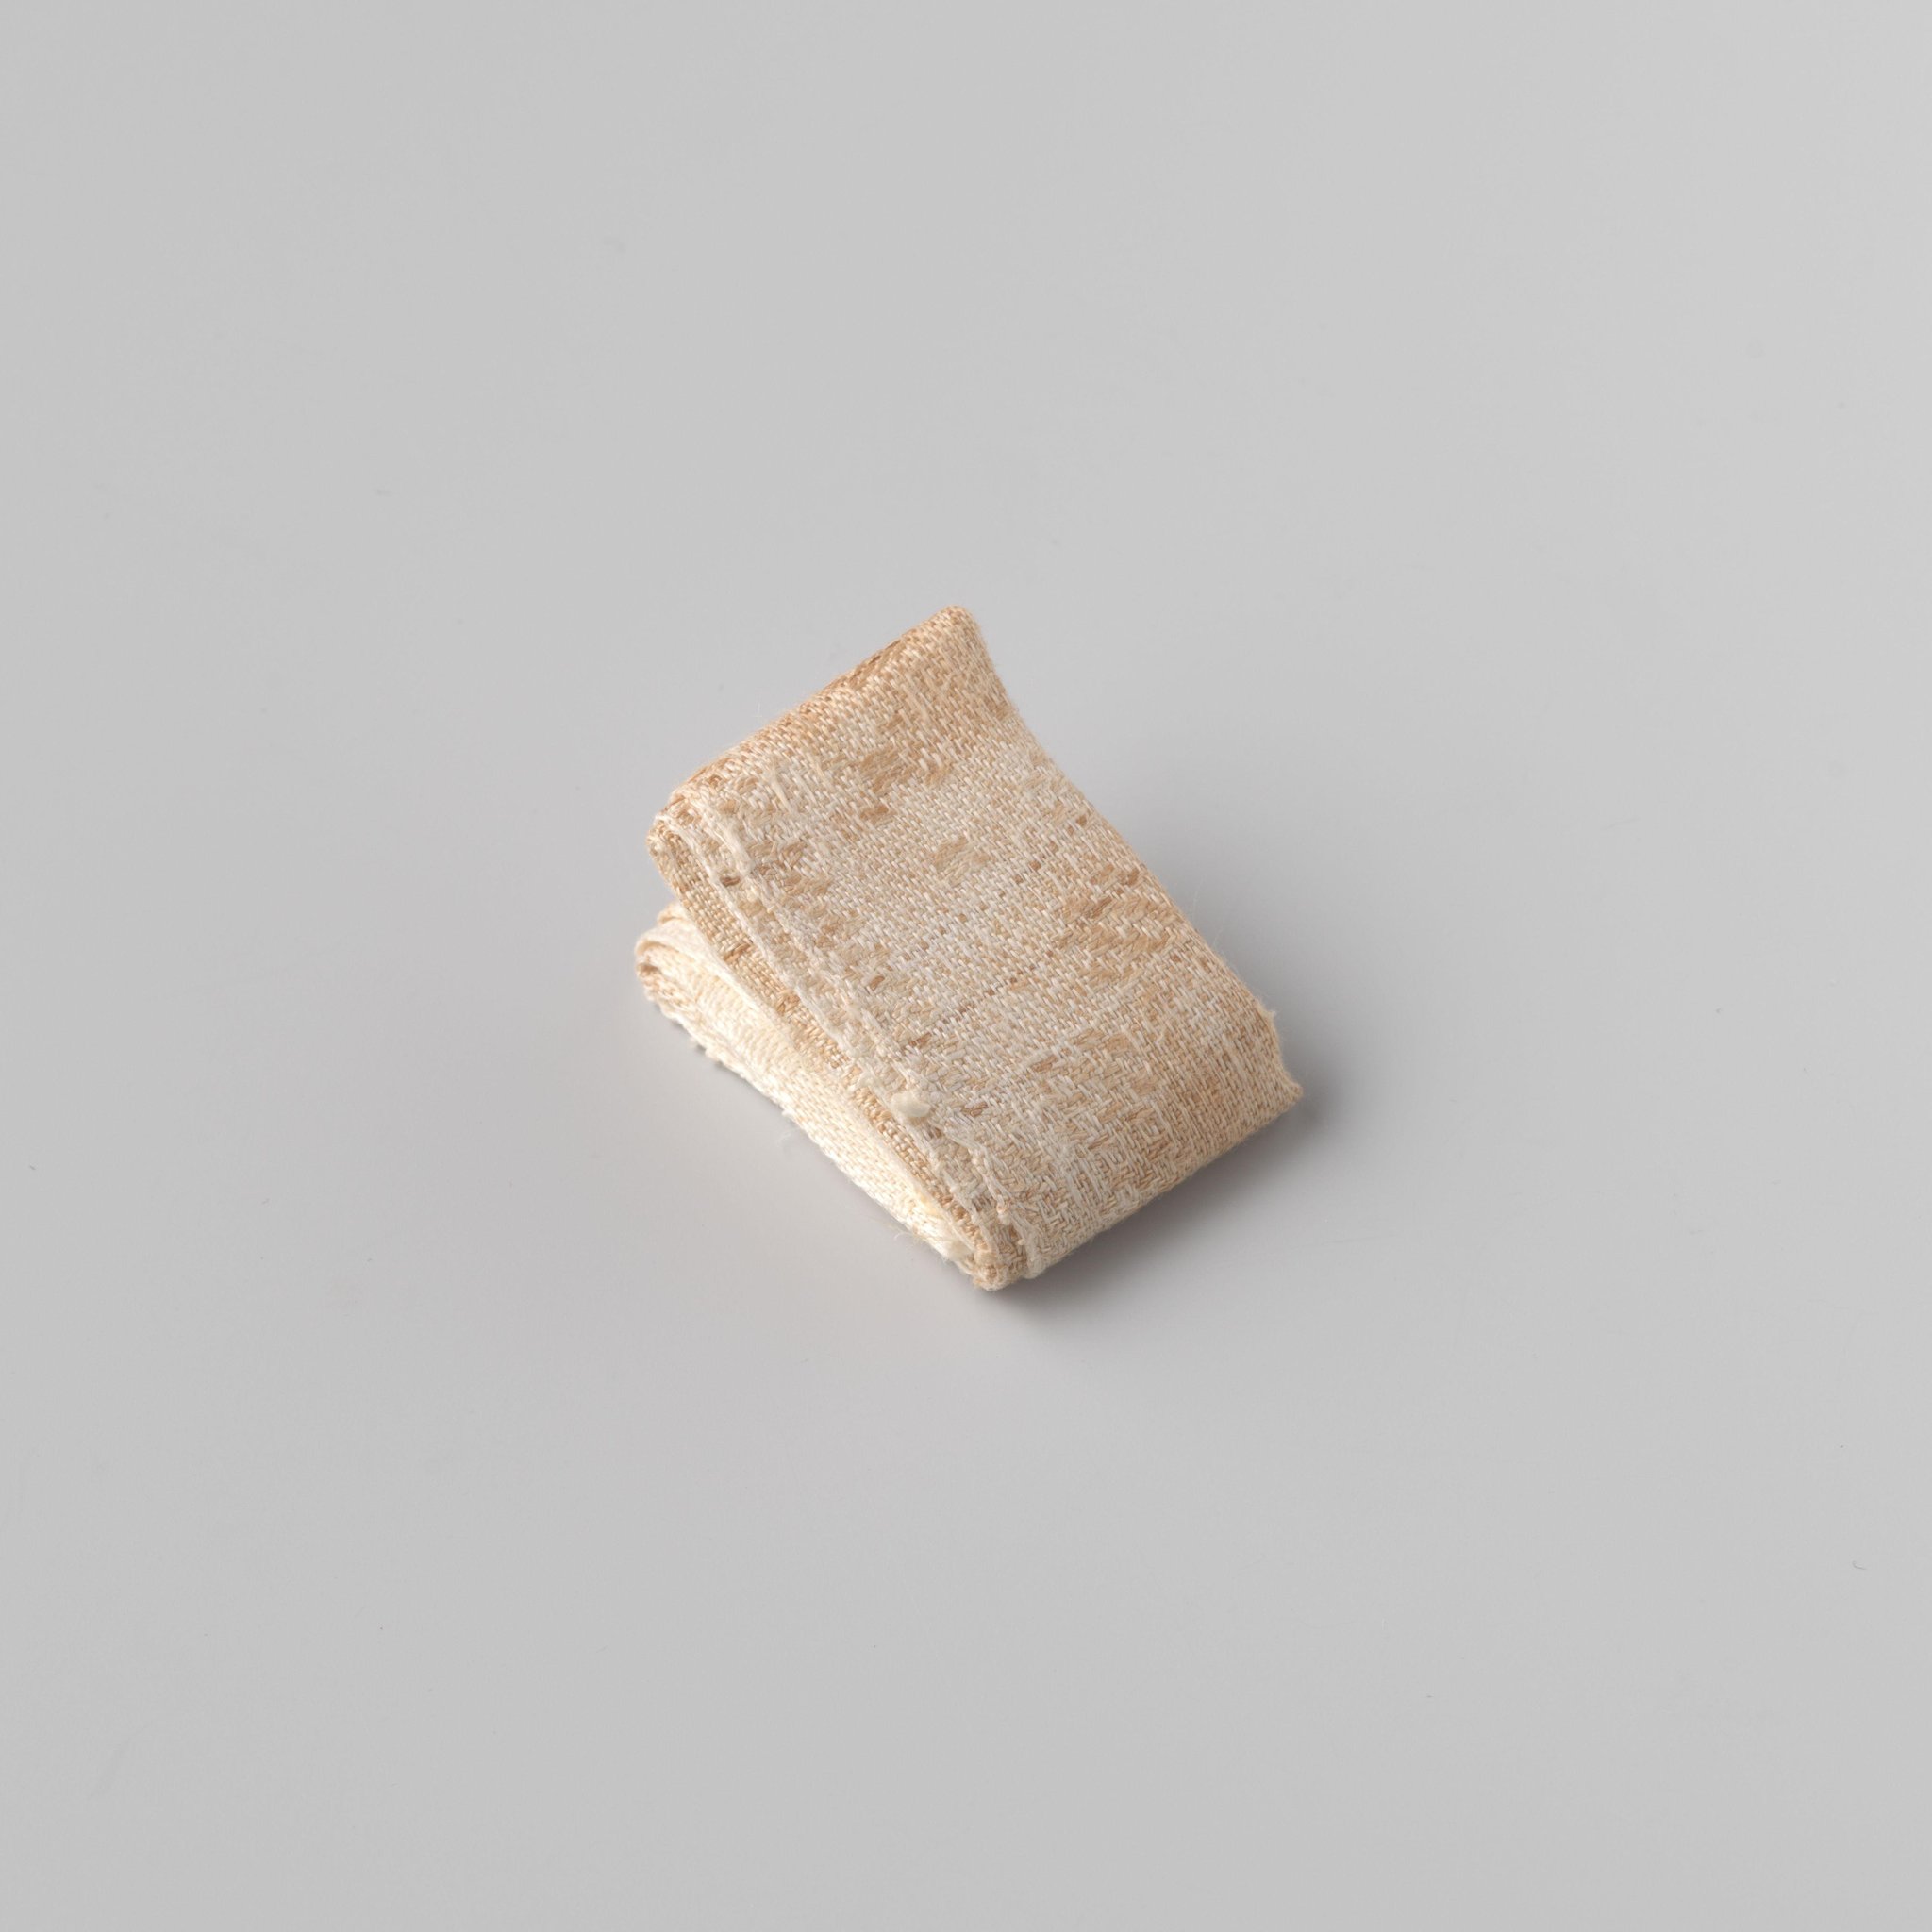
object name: miniature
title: Linnen servet van damastweefsel, met centraal ingeweven monogram BO, waar boven en onder een vogel met opgeheven poot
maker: Anonymous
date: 1690-1710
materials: linen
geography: amsterdam